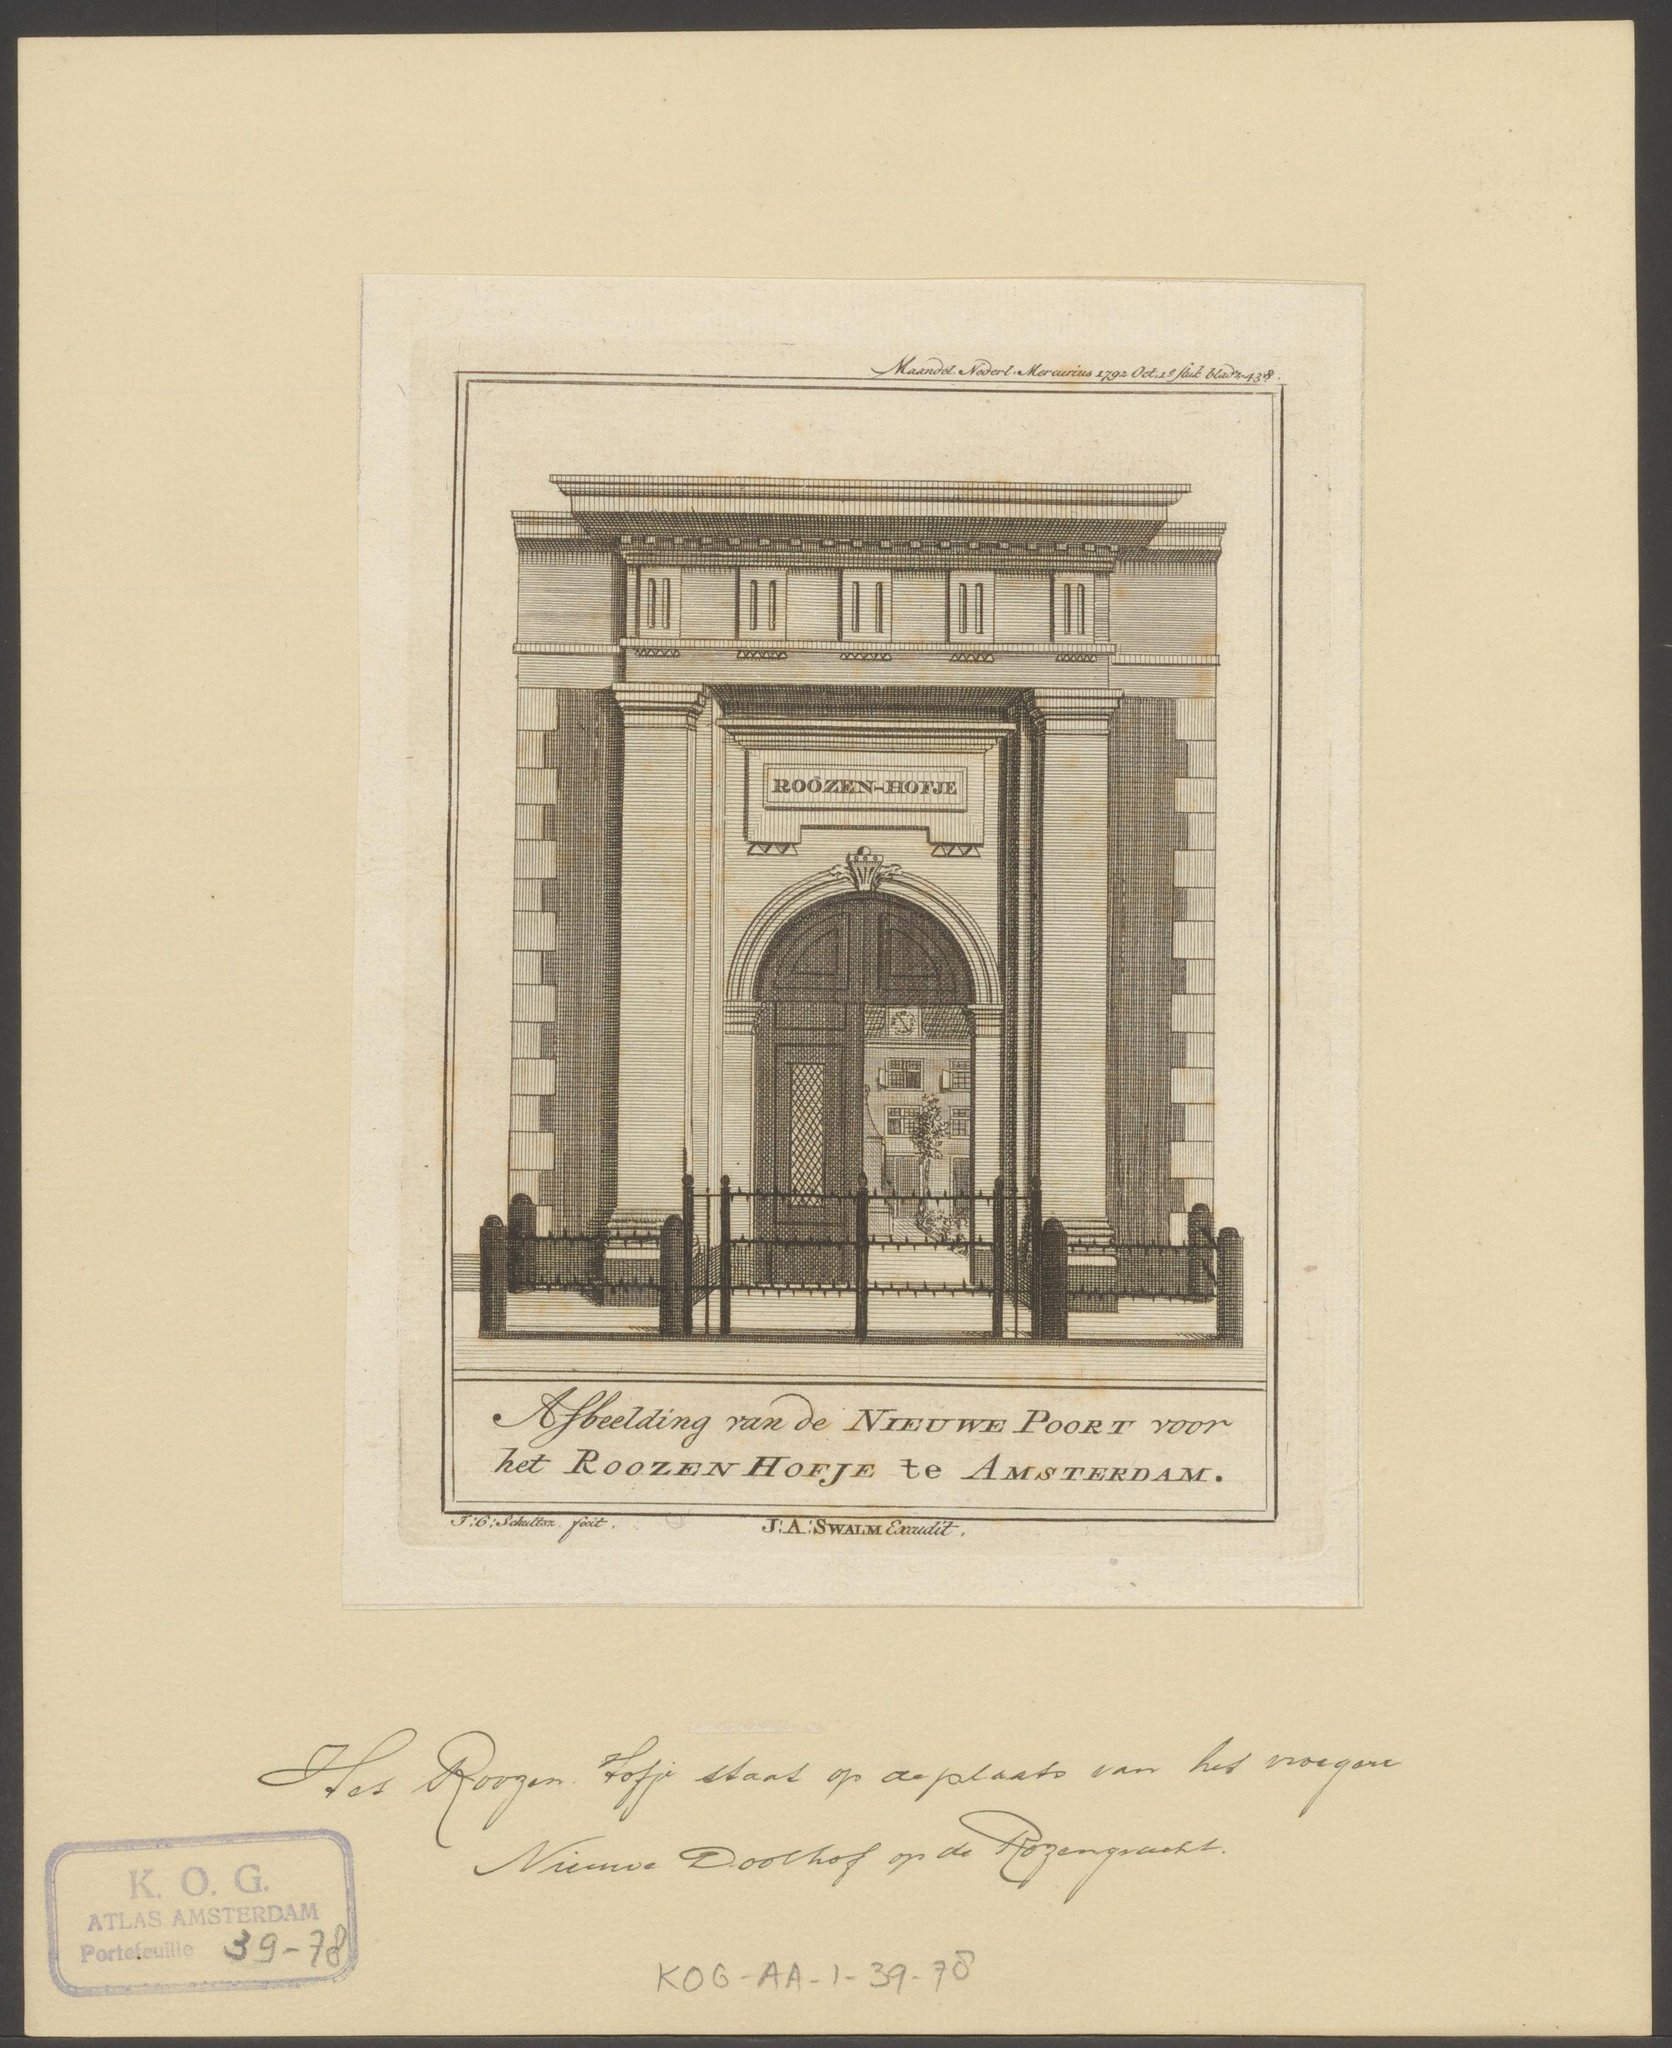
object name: print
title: Afbeelding van de Nieuwe Poort voor het Roozen Hofje te Amsterdam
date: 1710-1792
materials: paper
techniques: engraving, etching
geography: amsterdam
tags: alms-house (dutch: 'hofje'), gate, entrance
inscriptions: collector's mark: Lugt 1641b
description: Onderwerpsrubriek binnen de Atlas Amsterdam: Armwezen en liefdadige instellingen: III. Verschillende gestichten en instellingen / Hofjes: 't Roozenhofje - Suykerhofje - St. Andrieshofje.